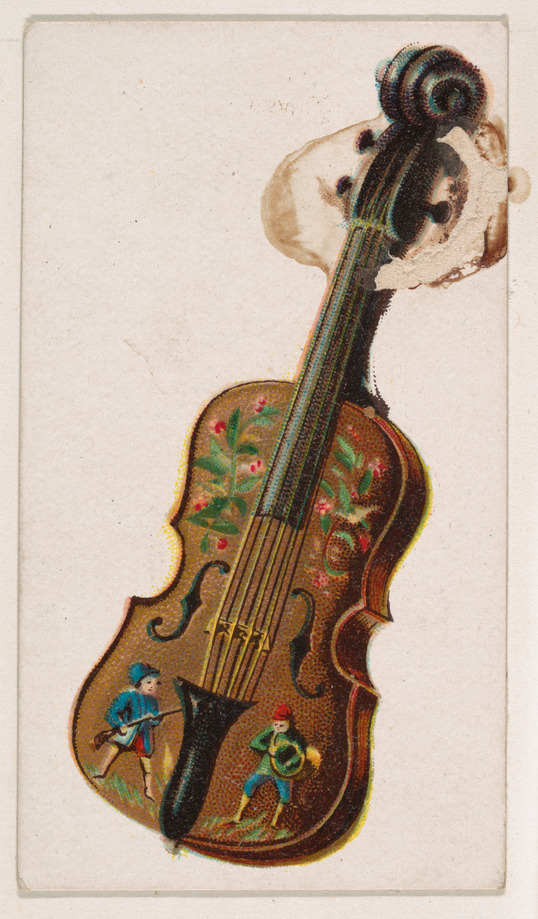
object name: print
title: Violin, from the Novelties series (N228, Type 5) issued by Kinney Bros.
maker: kinney brothers tobacco company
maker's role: publisher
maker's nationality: american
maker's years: 1869-2011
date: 1889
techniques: color lithograph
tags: violins